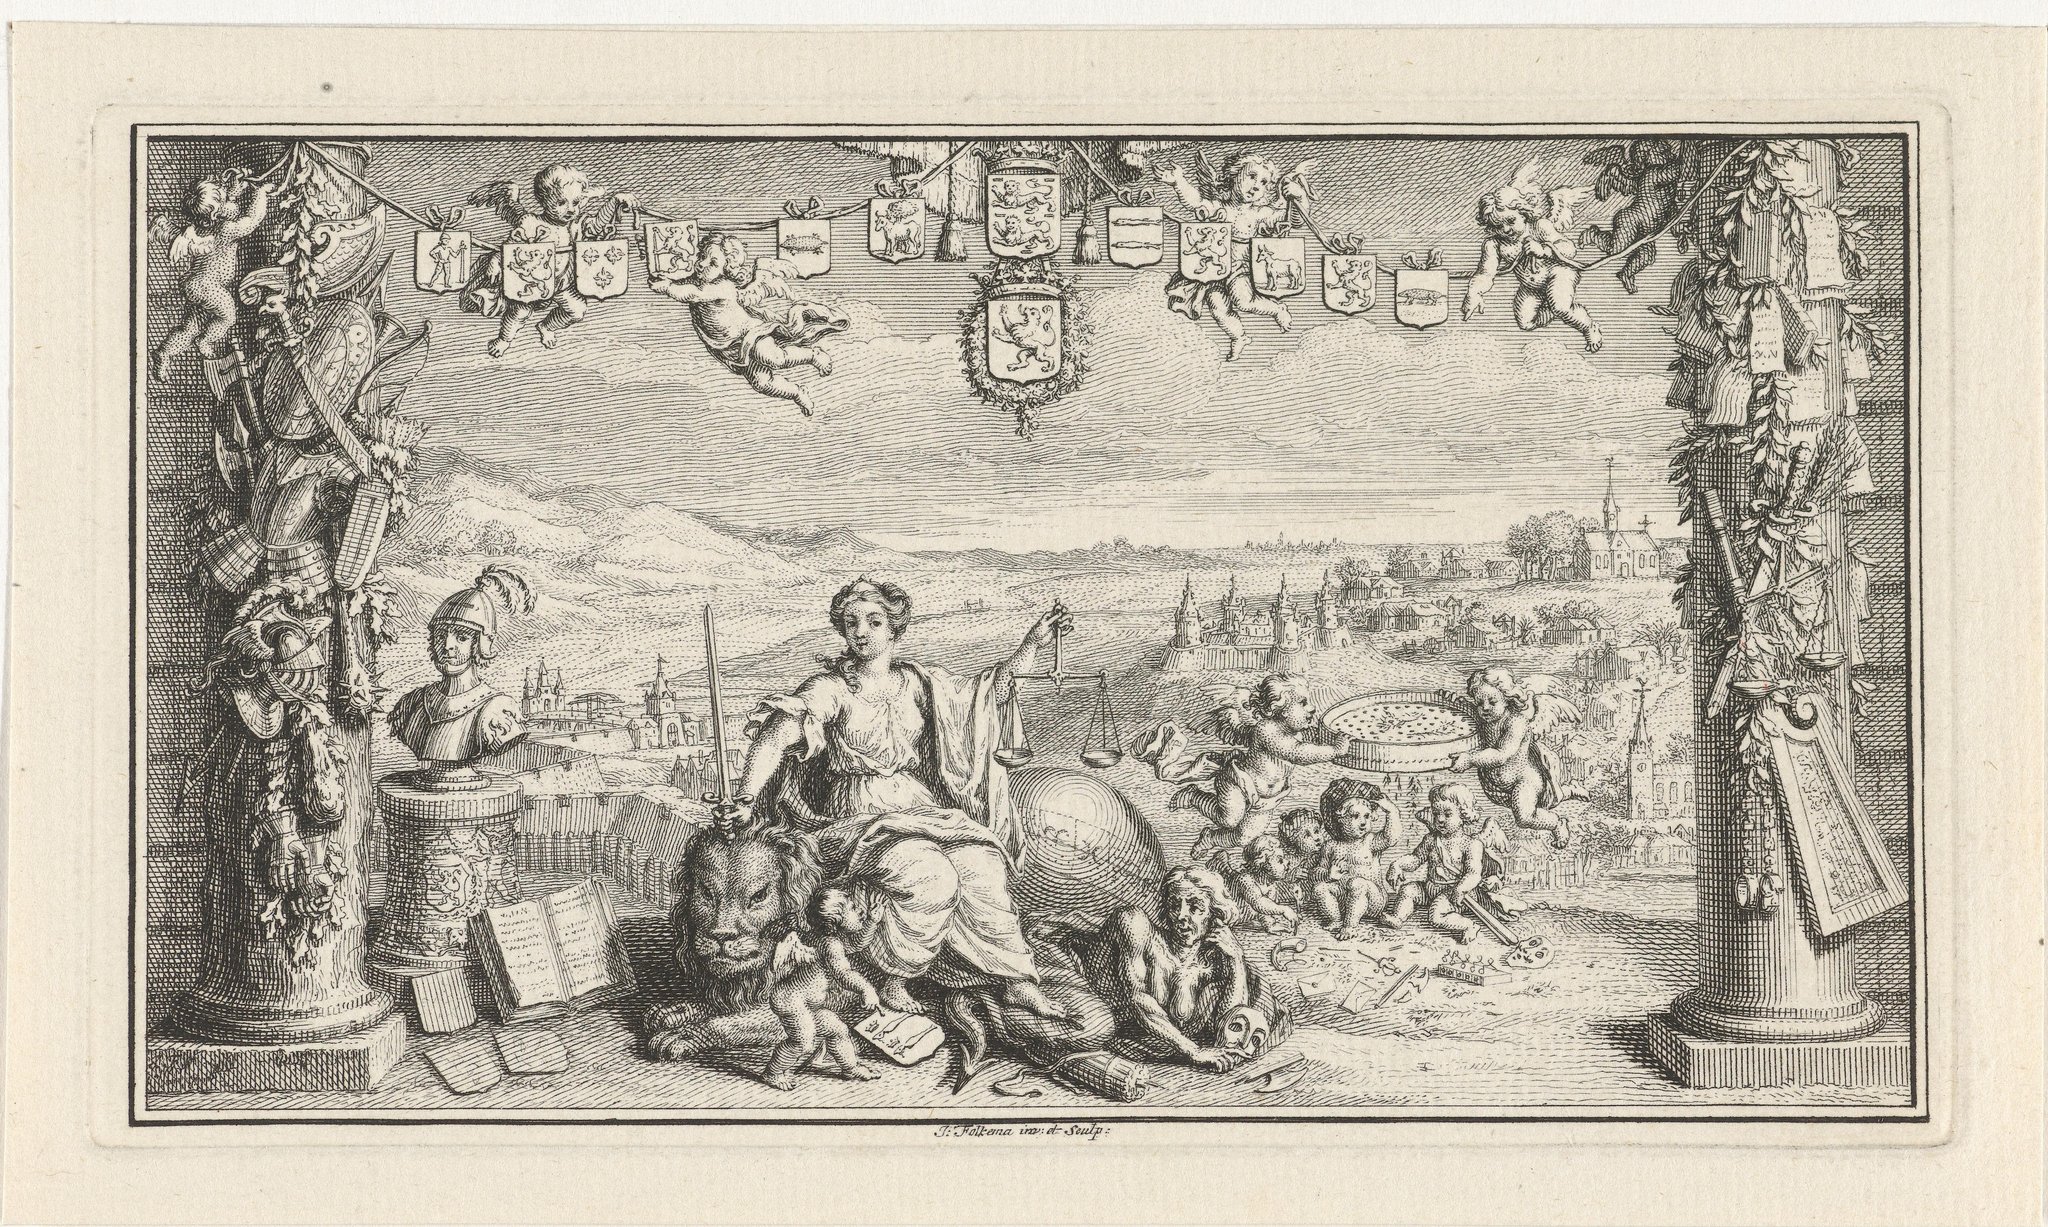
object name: print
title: Allegorie op de rechtvaardigheid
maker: jacob folkema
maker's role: draughtsman, print maker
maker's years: 1692-1767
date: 1702-1767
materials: paper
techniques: etching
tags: justice, 'justitia'; 'giustitia divina' (ripa) ~ one of the four cardinal virtues, cupids: 'amores', 'amoretti', 'putti', armorial bearing, heraldry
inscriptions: collector's mark: Lugt 240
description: De personificatie van rechtvaardigheid (Justitia) zit met een weegschaal en een zwaard in haar handen op een leeuw. Haar rechtervoet staat op een wapen met de beeltenis van twee gekroonde vissen, haar linkervoet trapt Bedrog tegen de grond. Op de achtergrond vliegen putti met een zeef. Links en rechts van Rechtvaardigheid staan zuilen die met elkaar verbonden zijn door een touw waaraan putti diverse wapenschilden hangen.